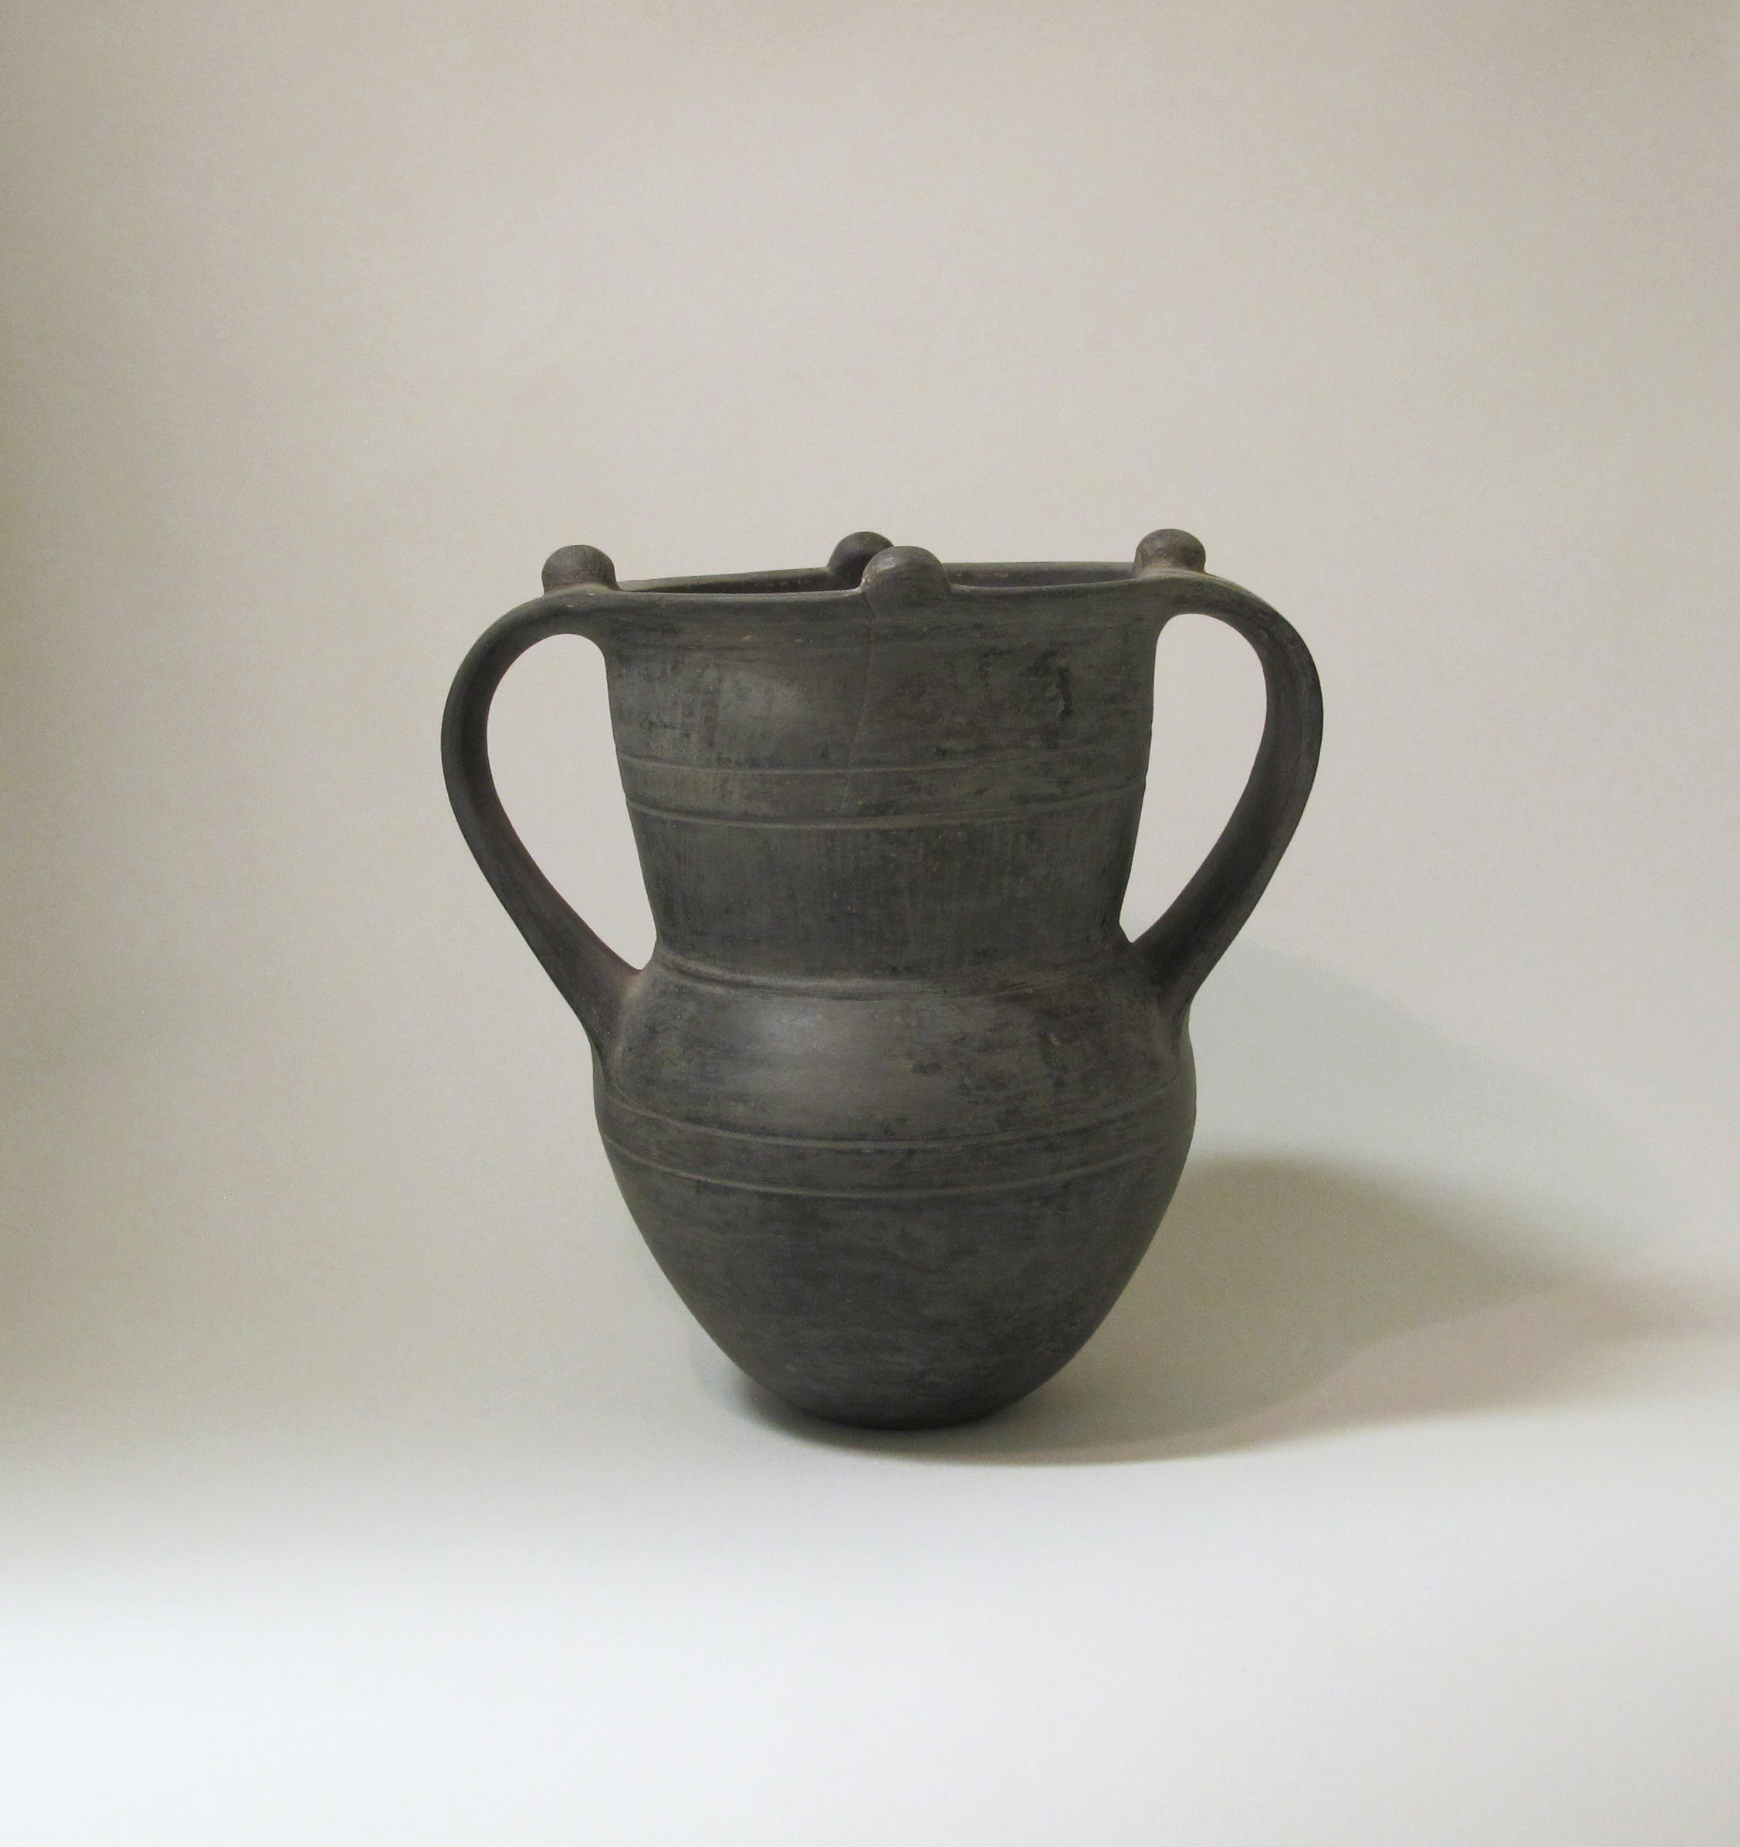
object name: vase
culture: etruscan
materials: terracotta